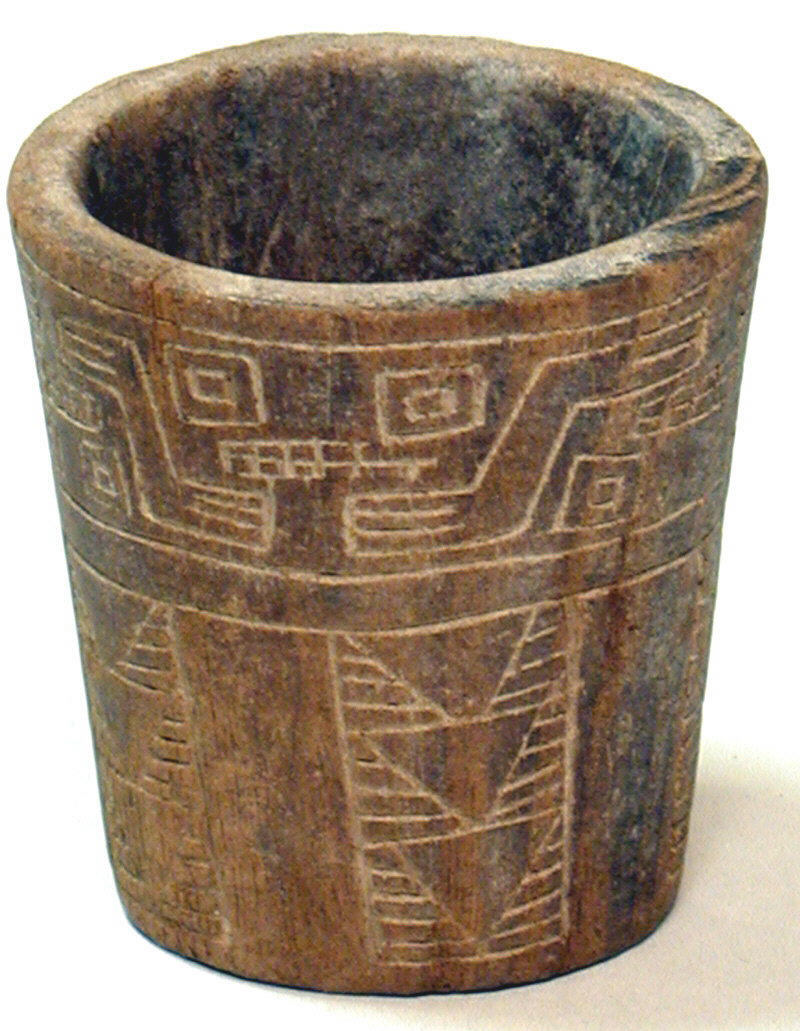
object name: kero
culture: inca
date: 1401-1533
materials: wood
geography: peru